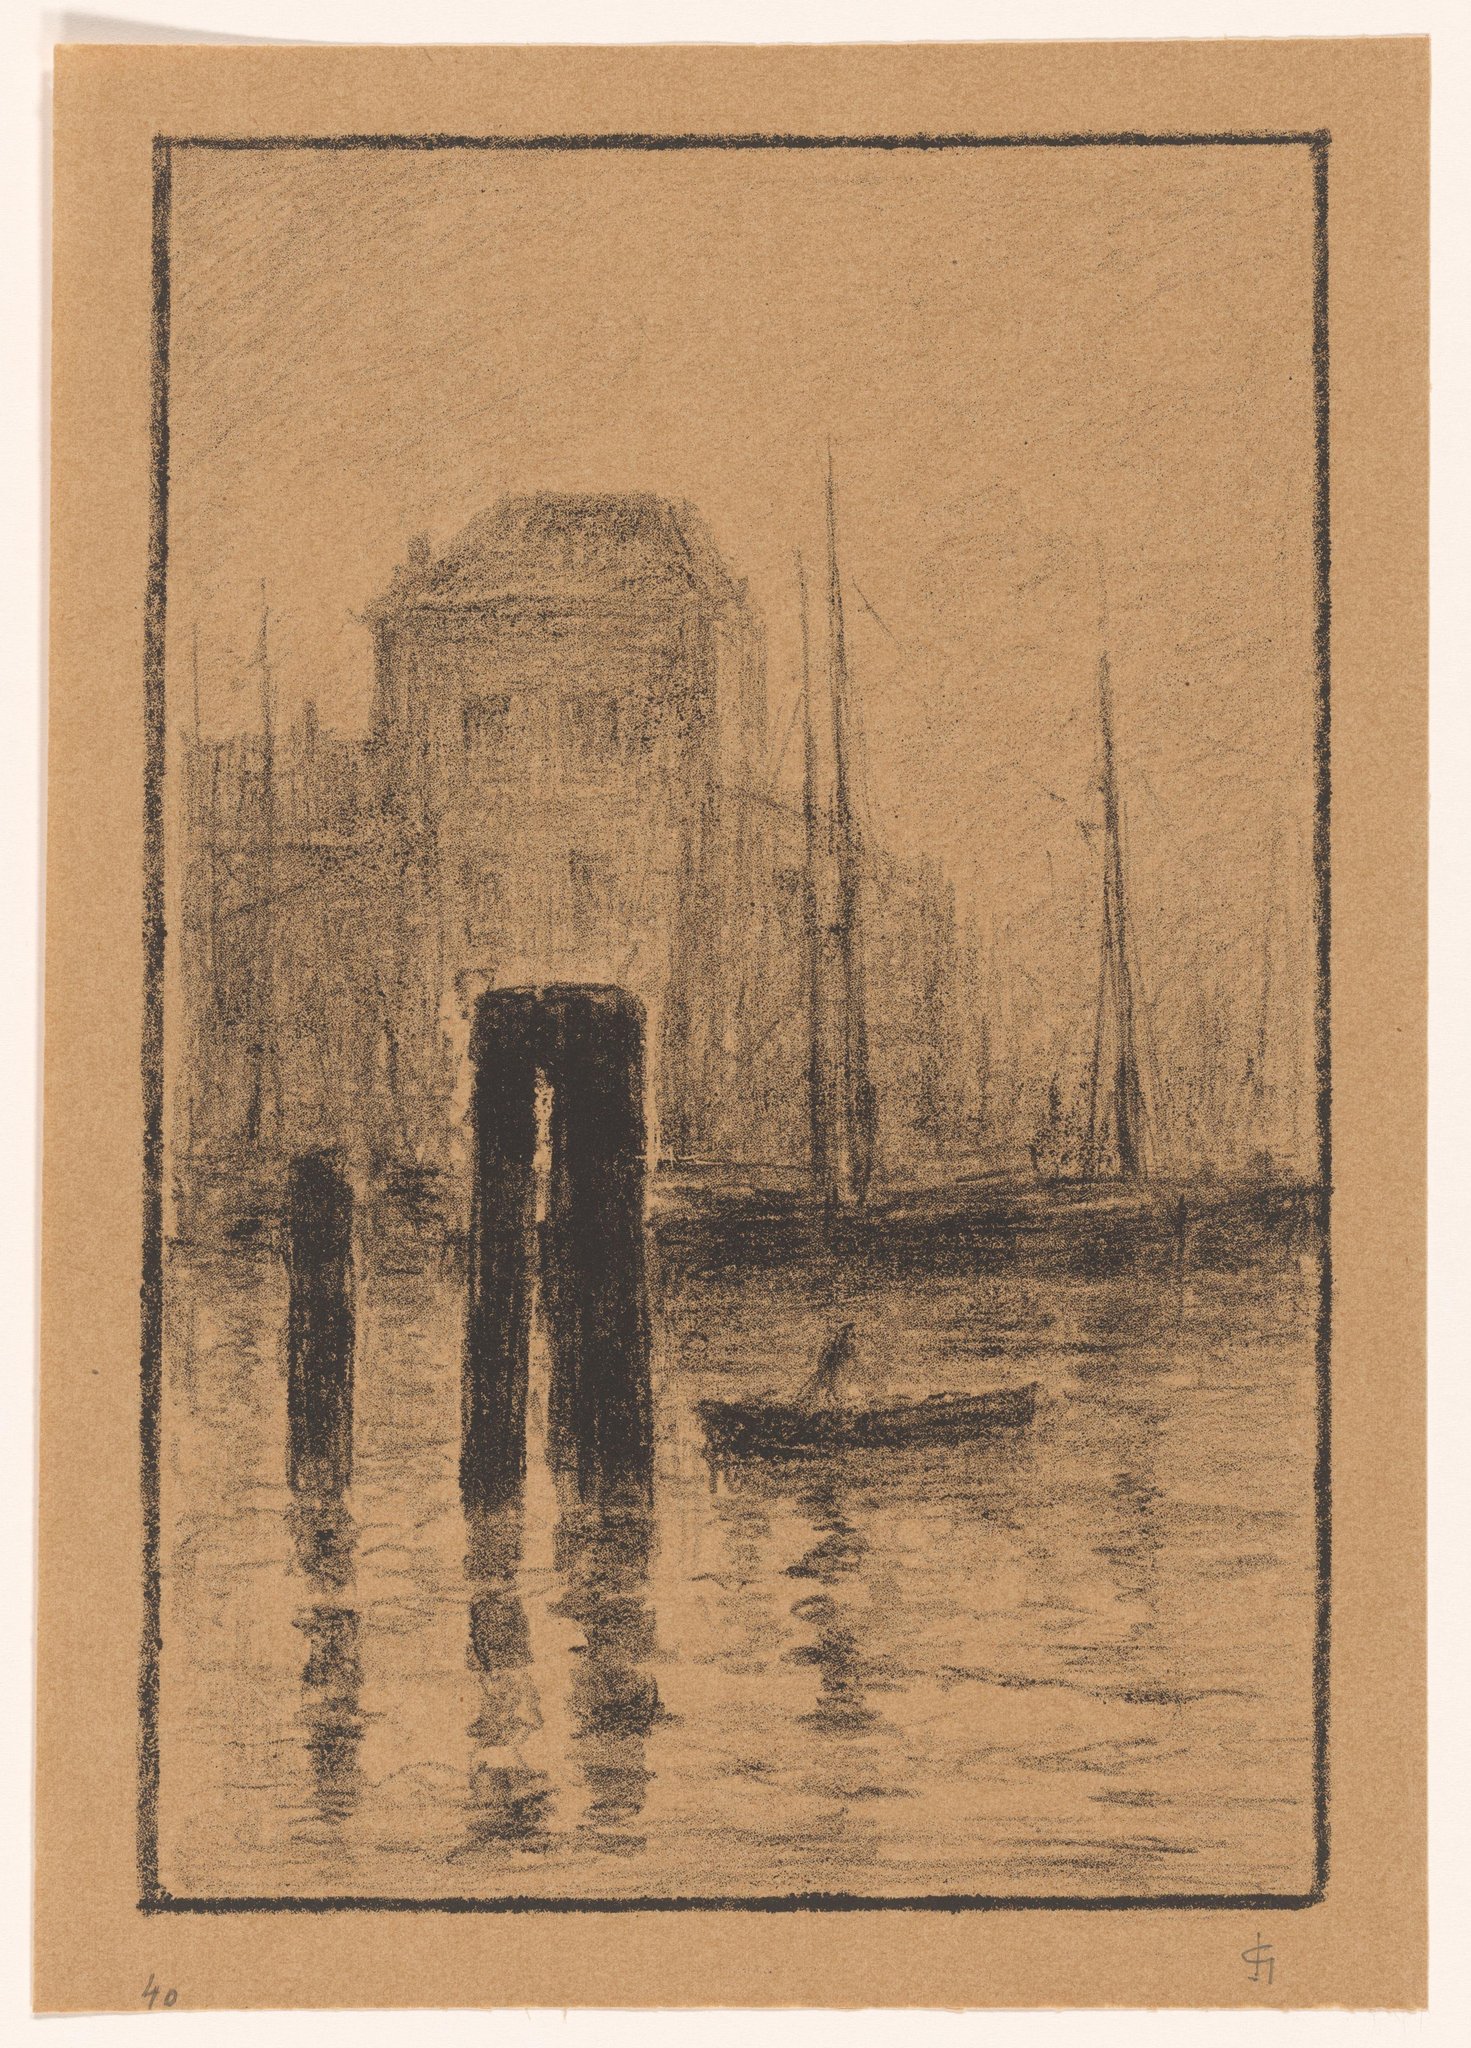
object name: print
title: Schemering in de haven van Cuxhaven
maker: carel nicolaas storm van s-gravesande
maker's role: draughtsman, print maker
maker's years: 1841-1924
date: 1851-1902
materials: paper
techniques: lithograph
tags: harbour, dusk, evening twilight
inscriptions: number: ‘40’, collector's mark: Lugt 2228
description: Mogelijk vermeld in: Storm van 's-Gravesande, Charles. Catalogue des eaux-fortes et lithographies. New York: s.n., 1903, of in een onbekende latere uitgave van het manuscript. Vermoedelijk vermeld als catalogusnummer 40.